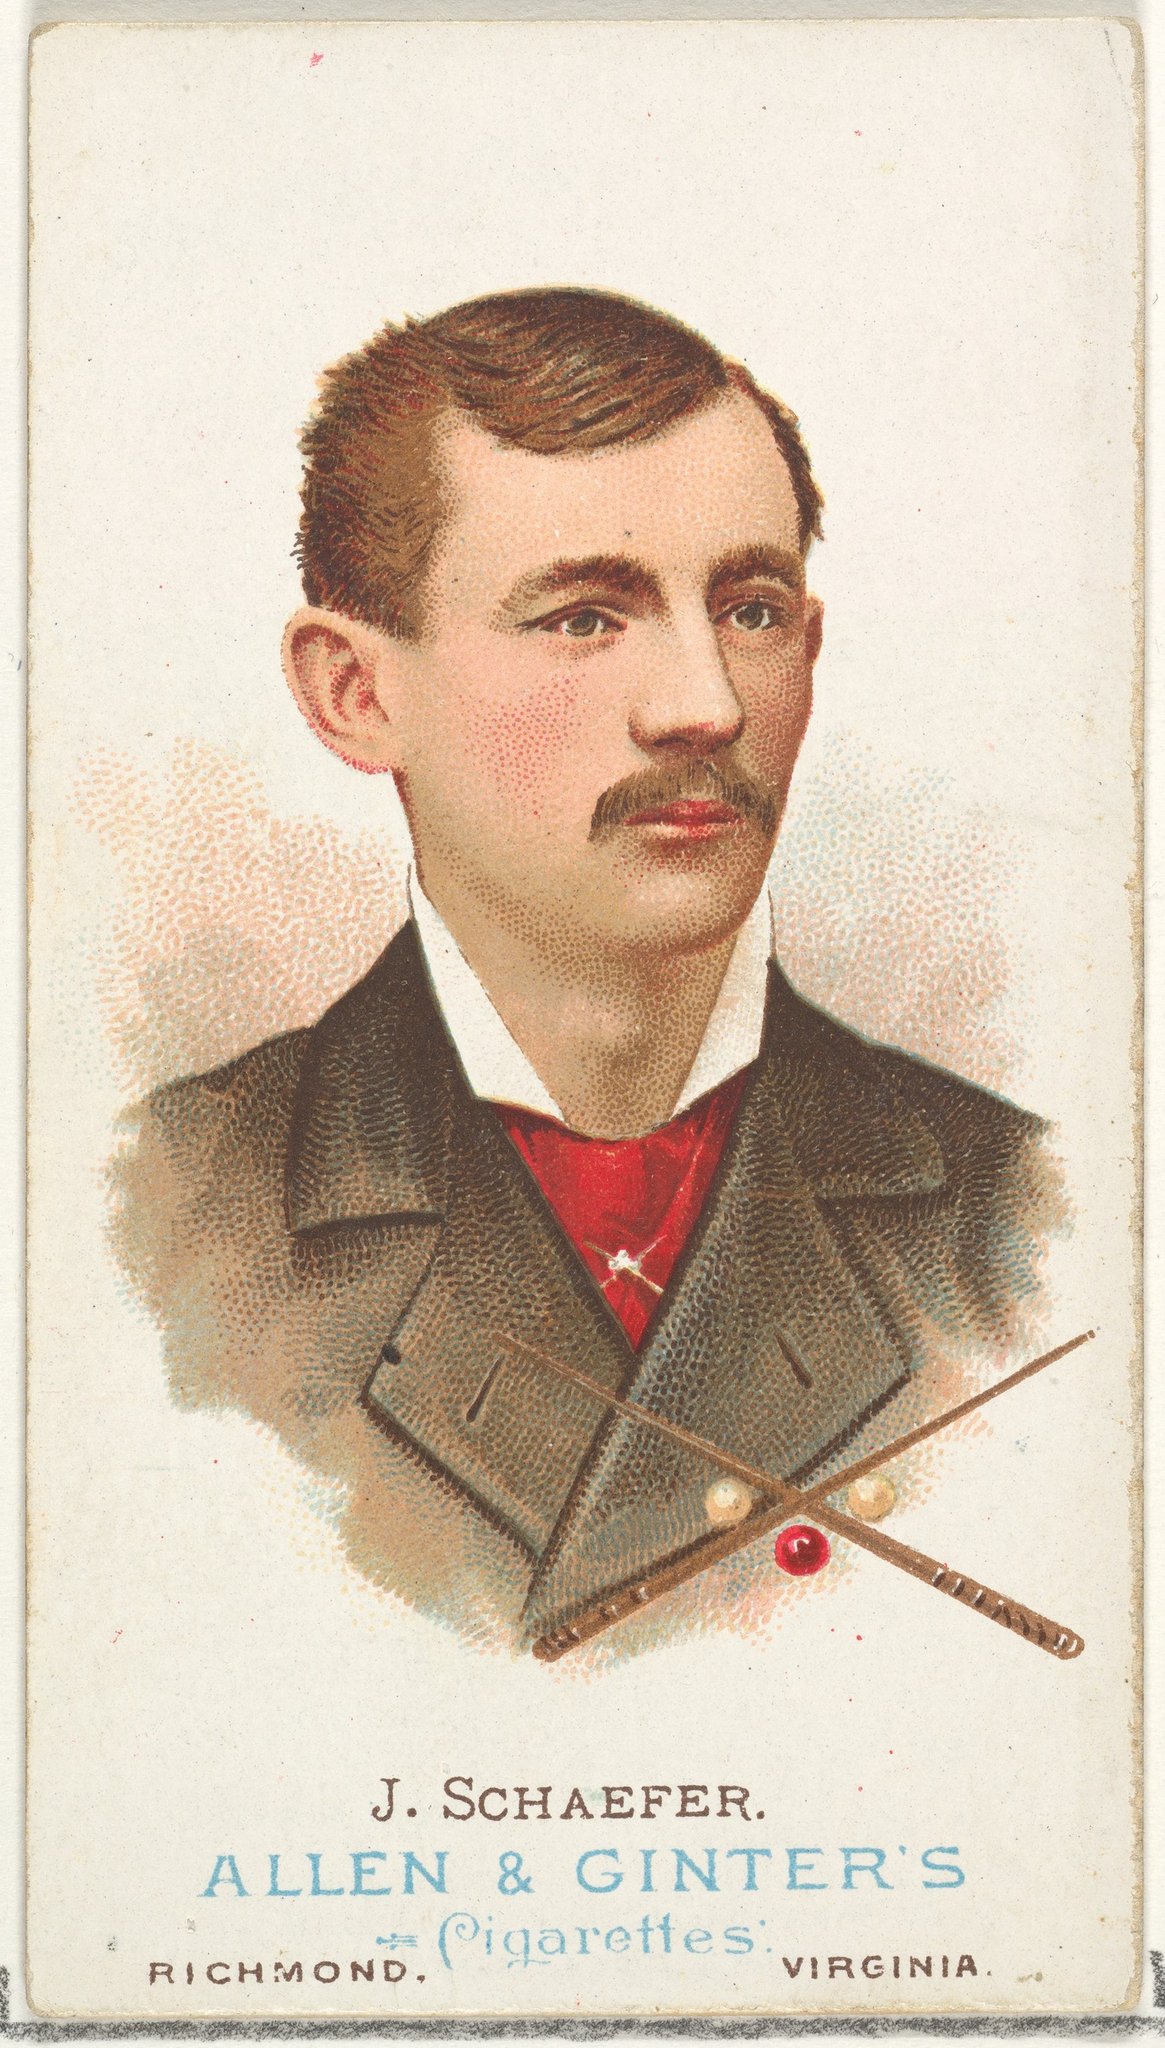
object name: print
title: Jacob Schaefer, Billiard Player, from World's Champions, Series 1 (N28) for Allen & Ginter Cigarettes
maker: allen & ginter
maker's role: publisher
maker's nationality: american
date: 1887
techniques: color lithograph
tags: men,portraits,billiards